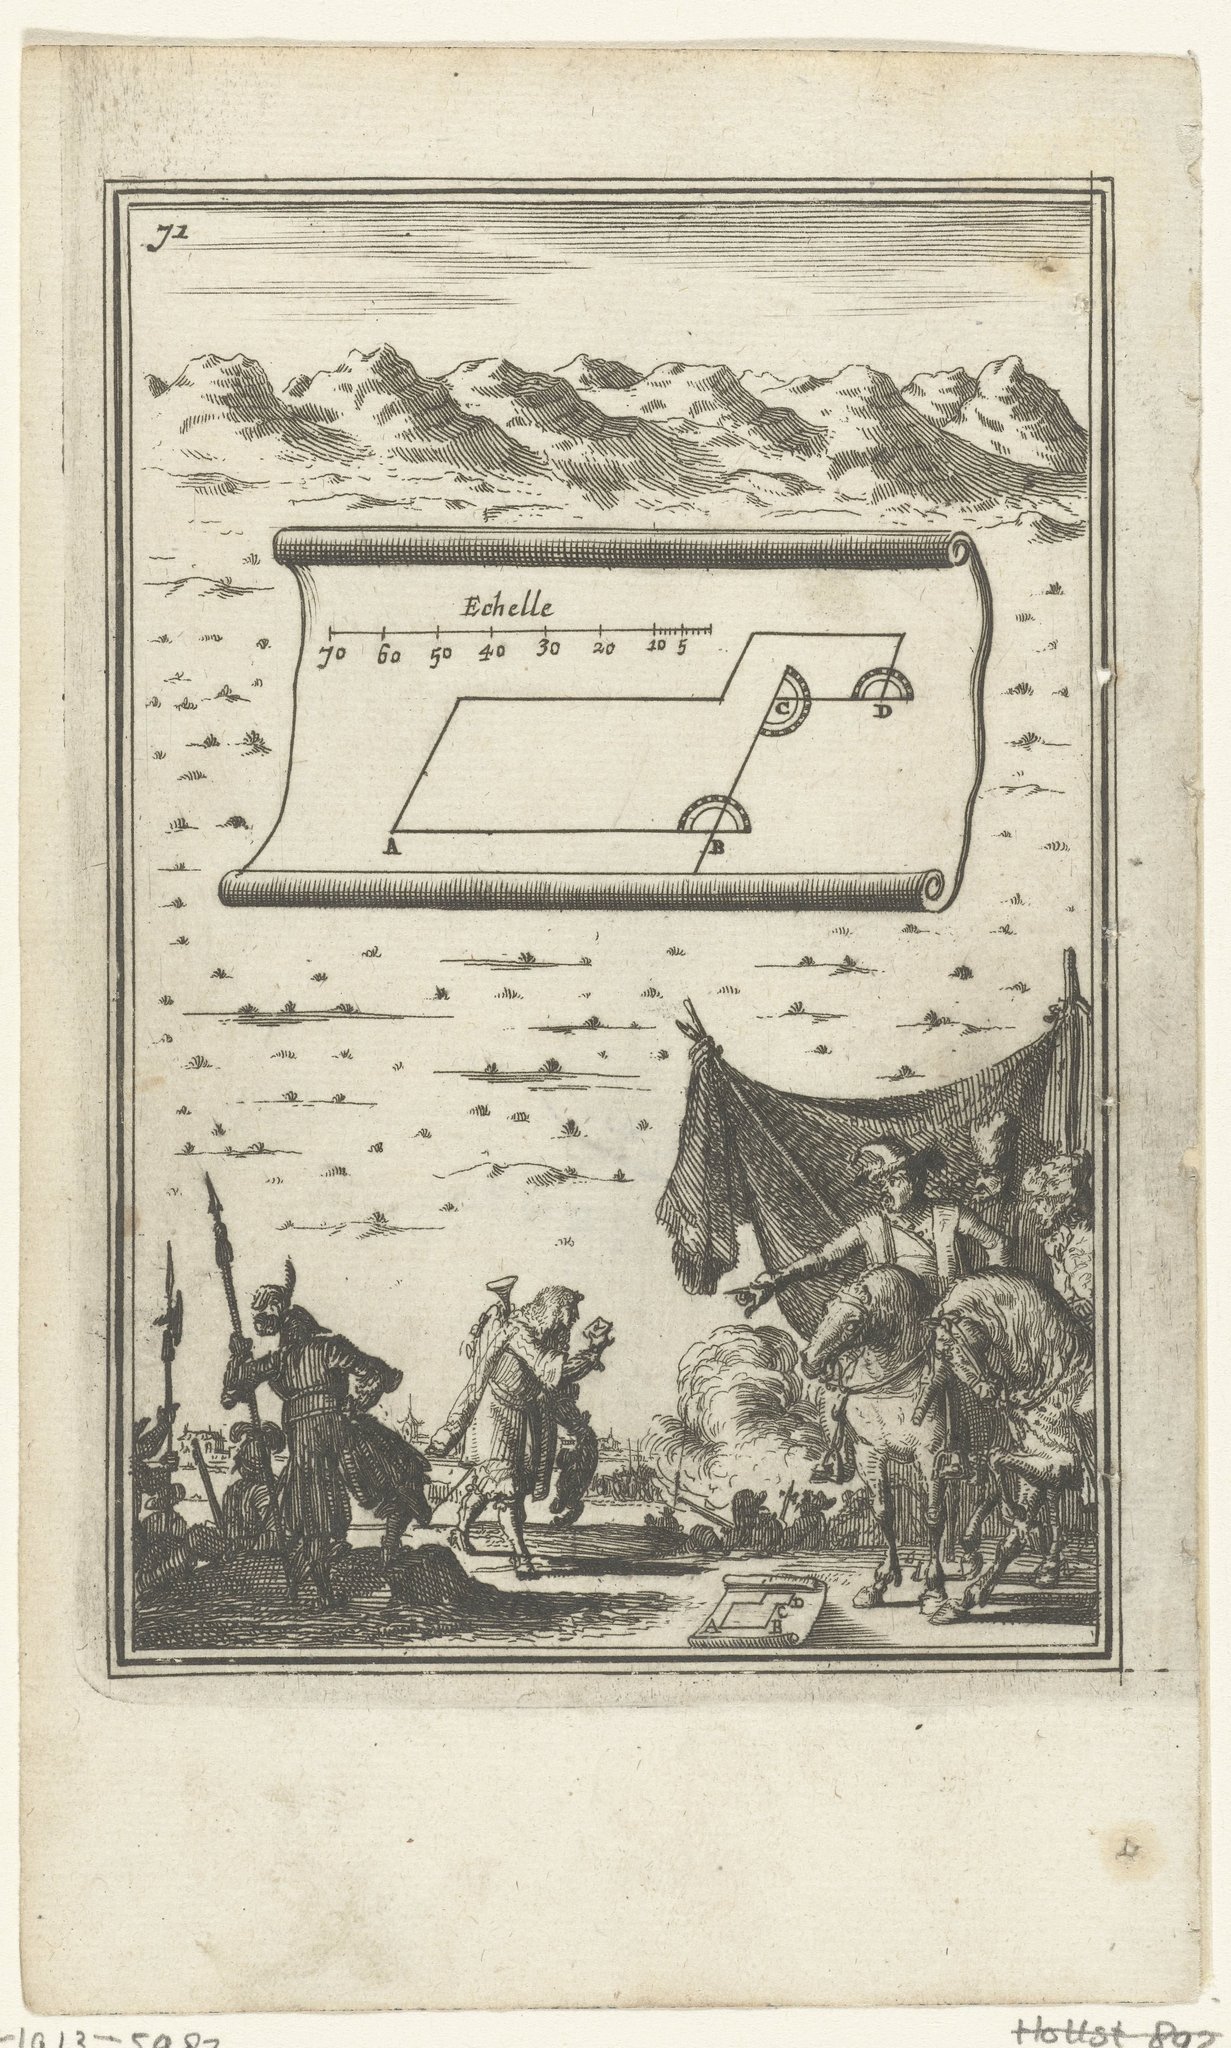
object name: print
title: Illustratie voor 'Den Arbeid van Mars' van Allain Manesson Mallet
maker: romeyn de hooghe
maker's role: draughtsman, goldsmith, painter, print maker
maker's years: 1645-1708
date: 1672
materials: paper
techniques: etching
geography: amsterdam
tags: riding a horse, ass, or mule; rider, horseman, mathematics, mountains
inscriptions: collector's mark: Lugt 2228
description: Kaart met een zeer summier grondplan voor een huis. Daaronder enkele heren te paard, van wie eentje wijst naar een man te voet die iets in zijn hand houdt. In de hoek linksboven het cijfer 71 (= het nummer van de pagina in het boek waartegenover de illustratie geplaatst is).